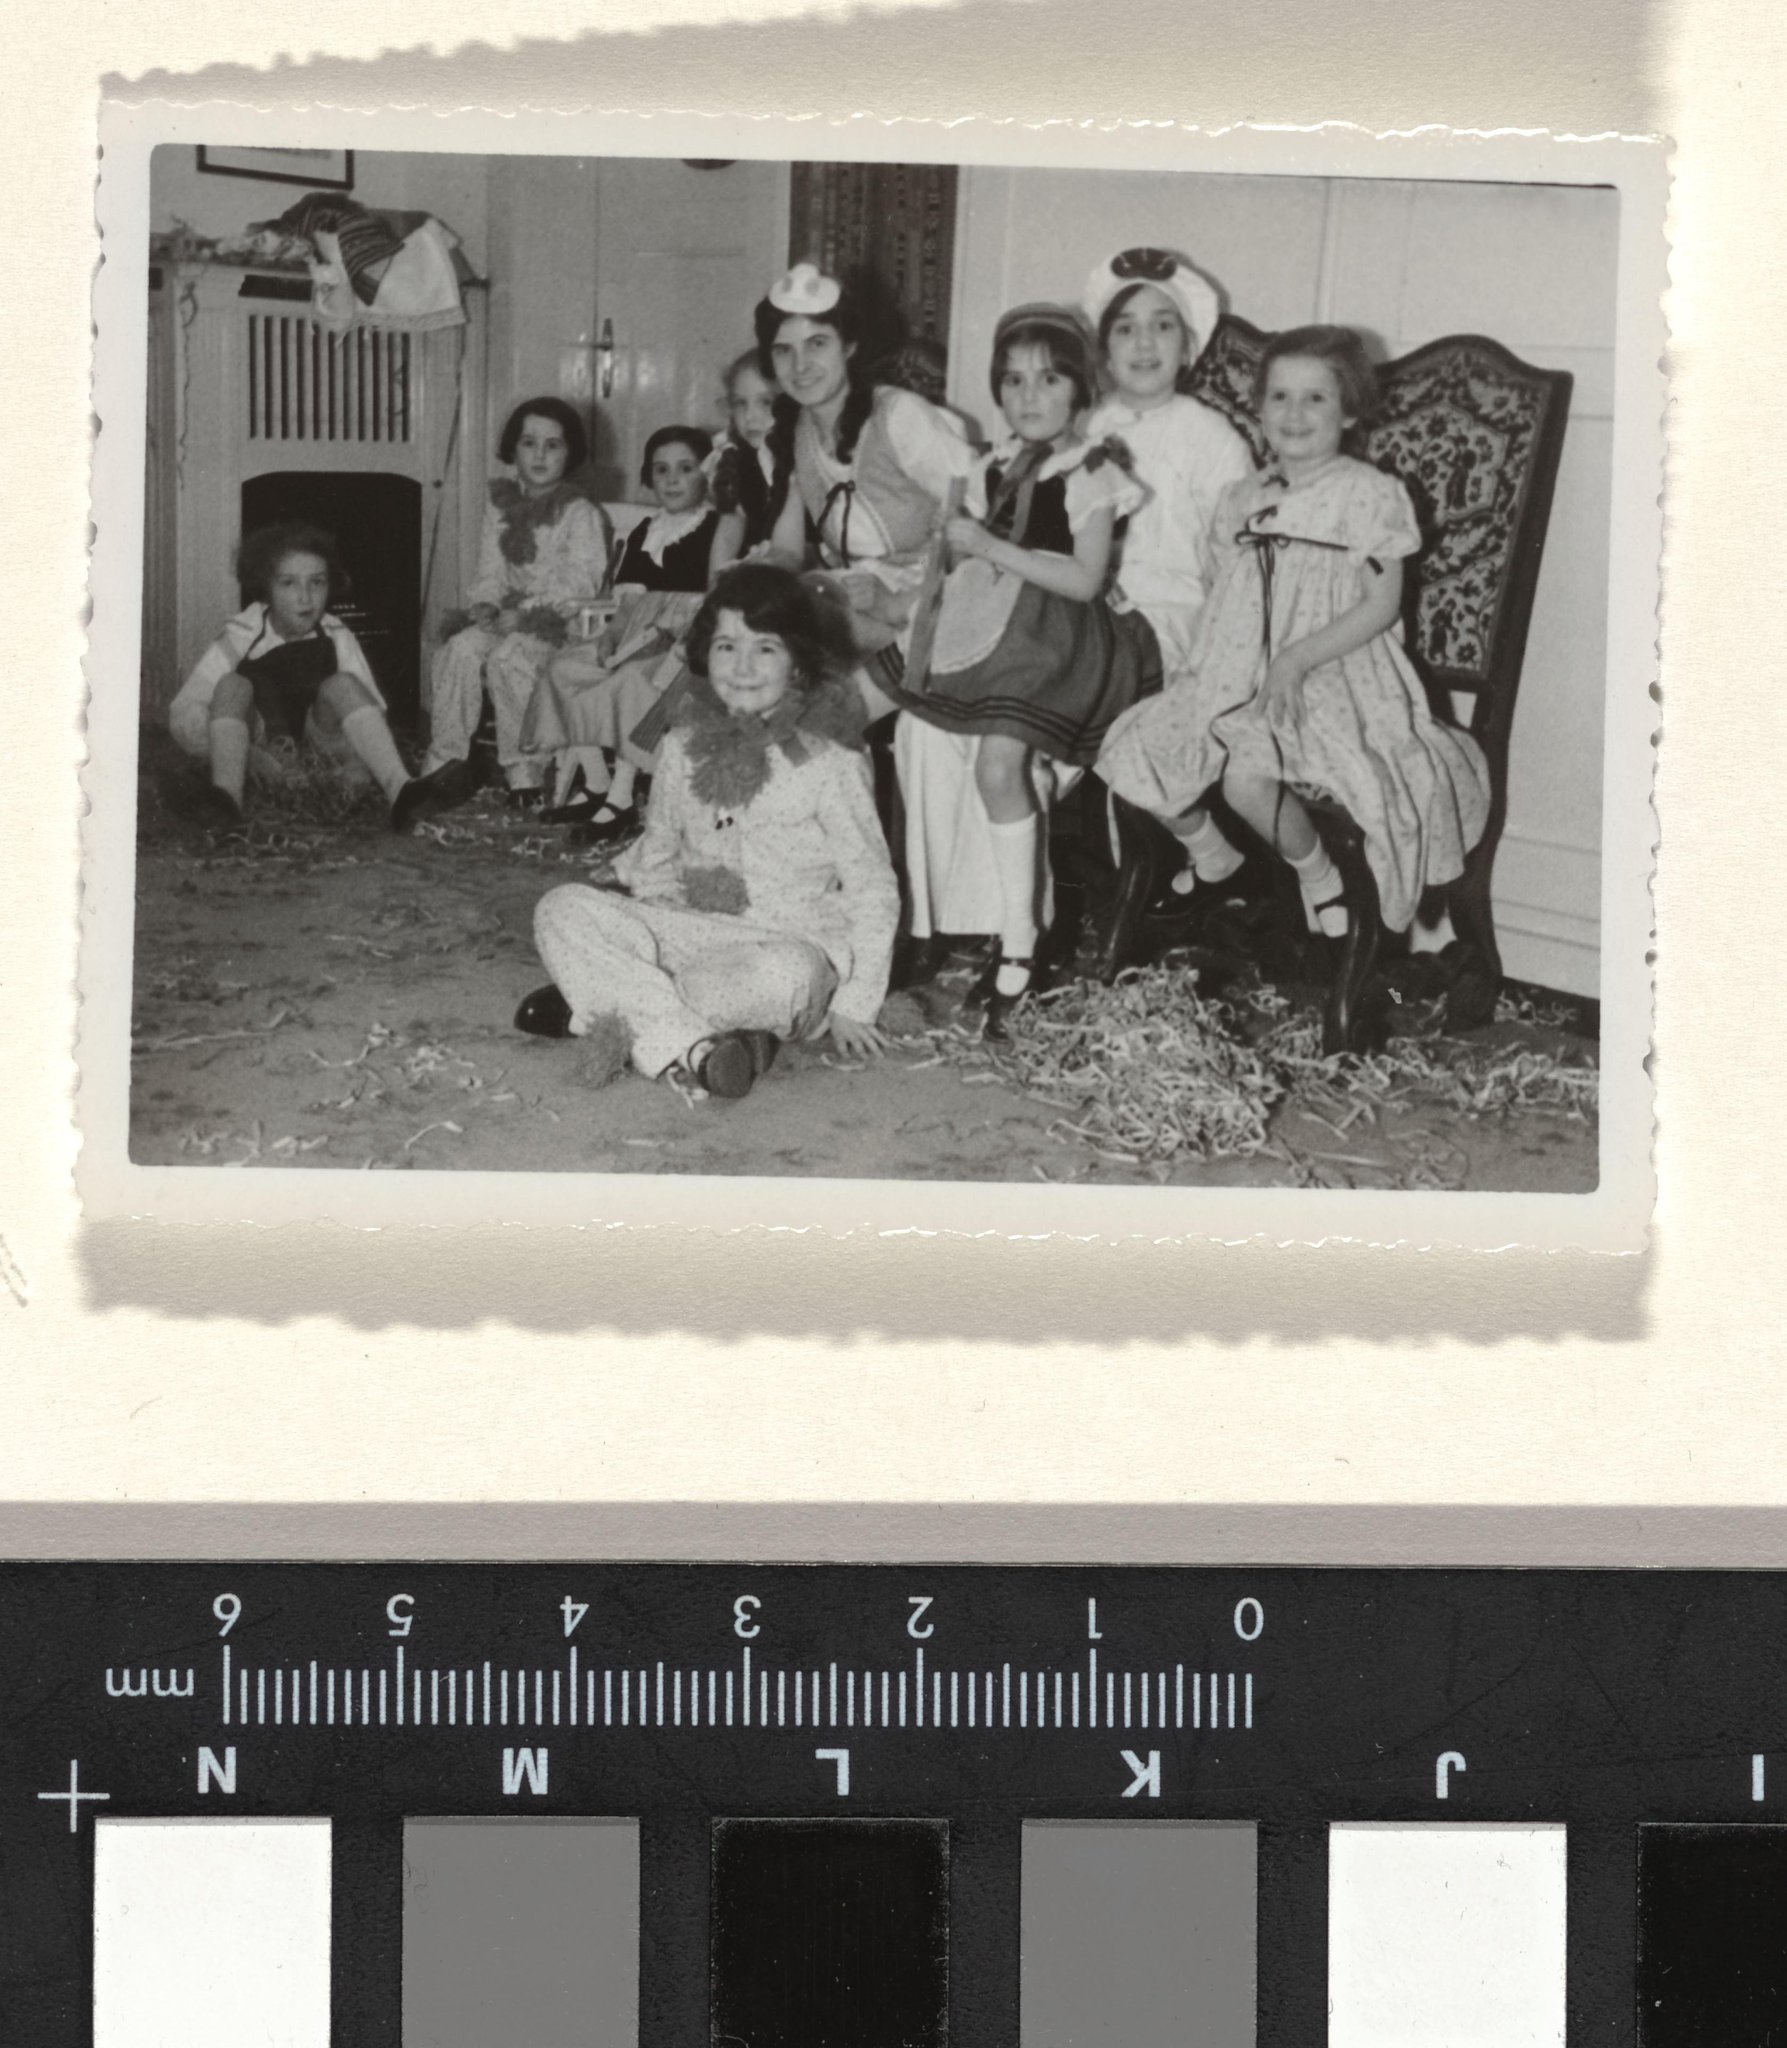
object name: photograph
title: Isabel Wachenheimer tijdens carnaval, in maart 1935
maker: Anonymous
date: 1903-1935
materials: photographic support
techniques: gelatin silver print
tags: leiden, isabel wachenheimer-elon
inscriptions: date: ‘März 1935’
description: Isabel Wachenheimer, uiterst rechts afgebeeld, zittend op een bank, met onbekende kinderen tijdens carnaval 1935.